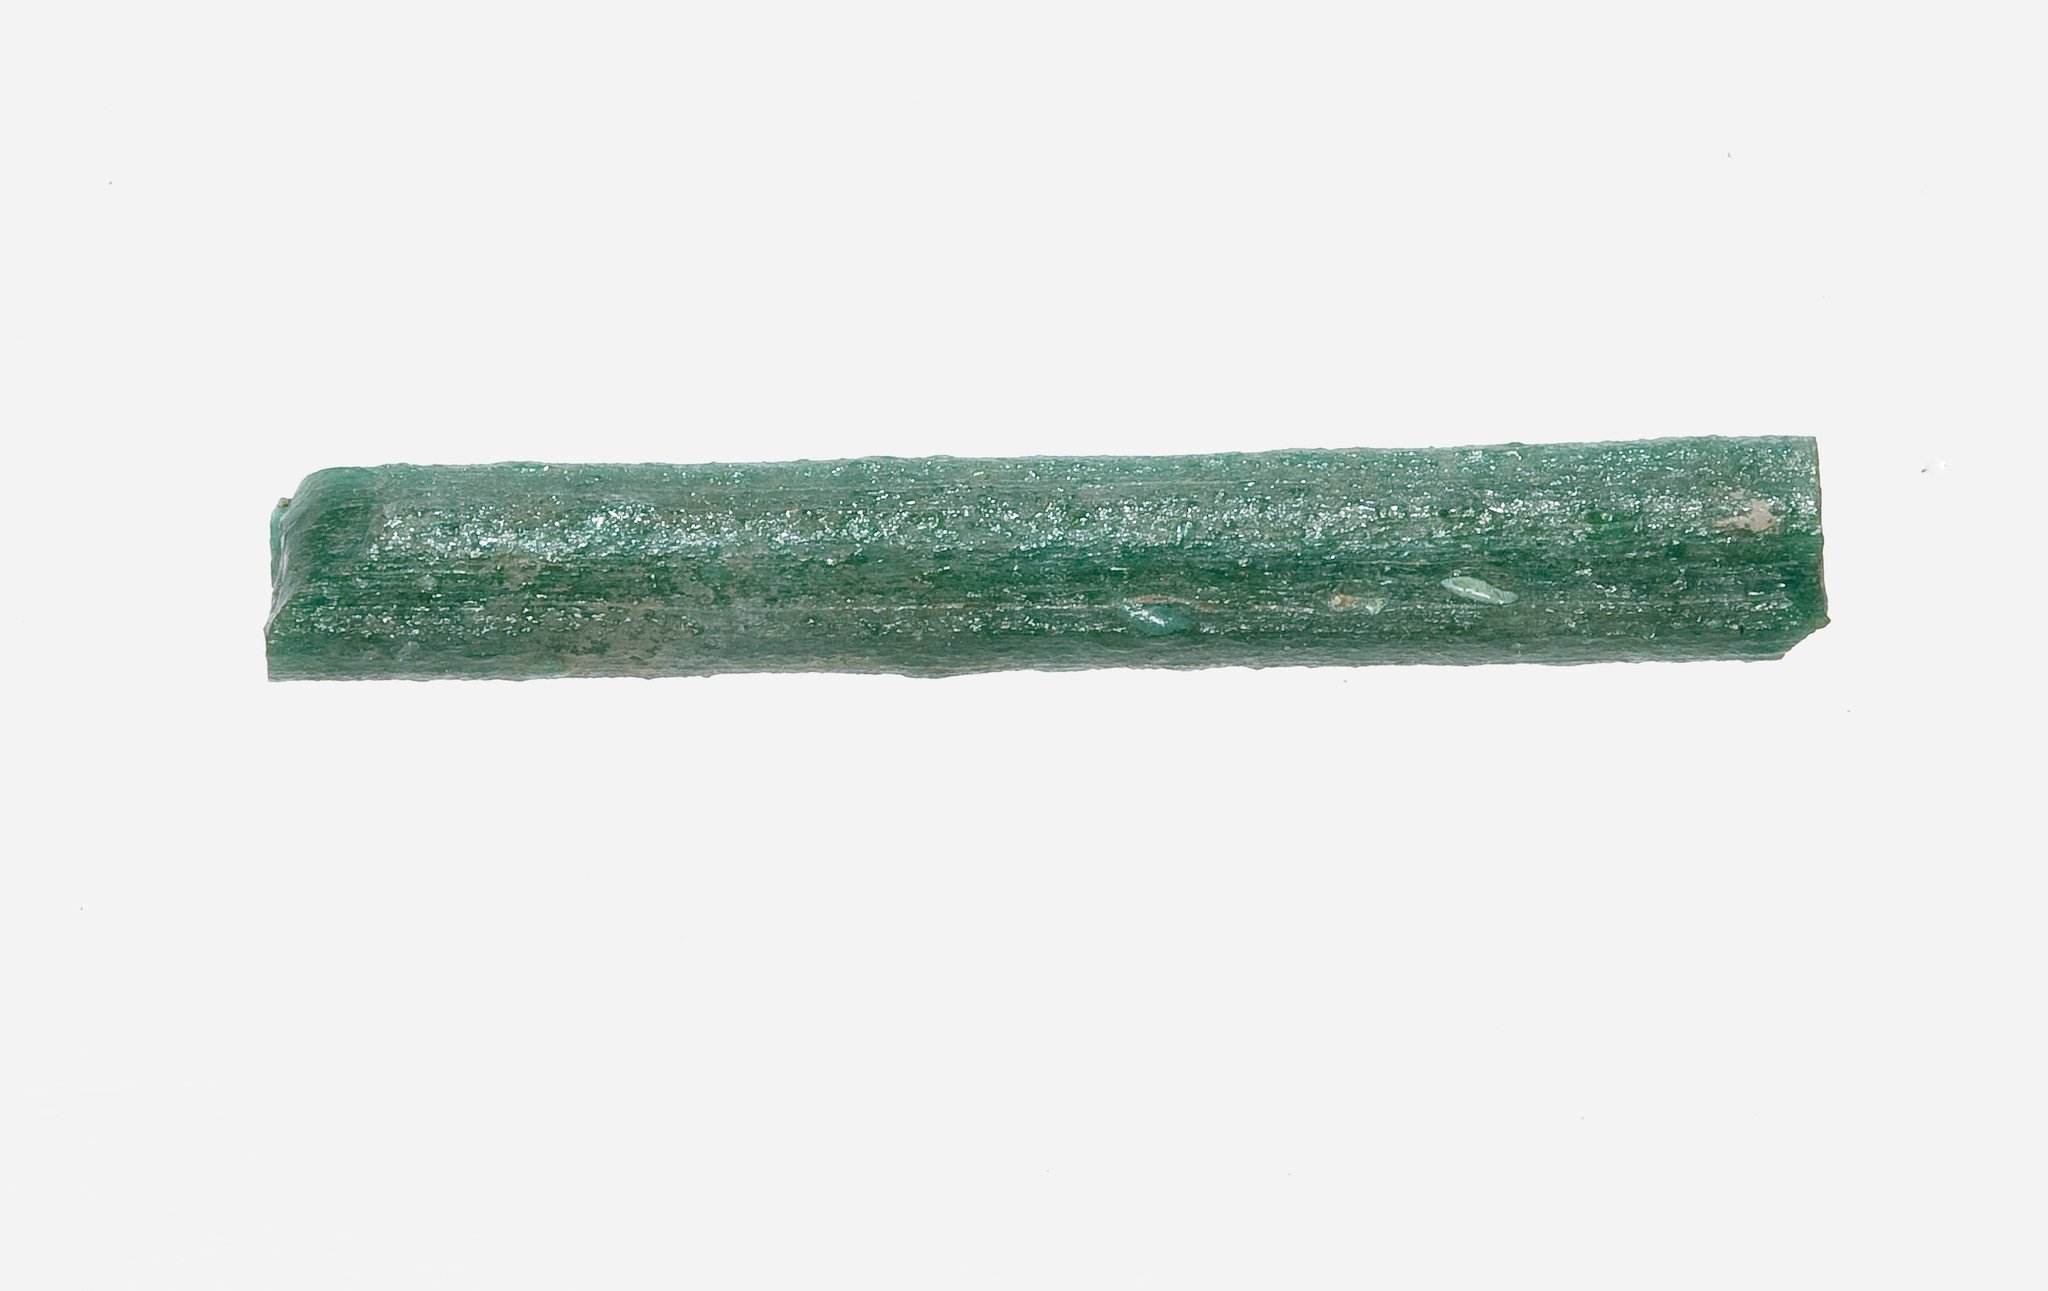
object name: glass rod, green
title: Rod of Opaque Green Glass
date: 1390-1352 BCE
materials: glass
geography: egypt